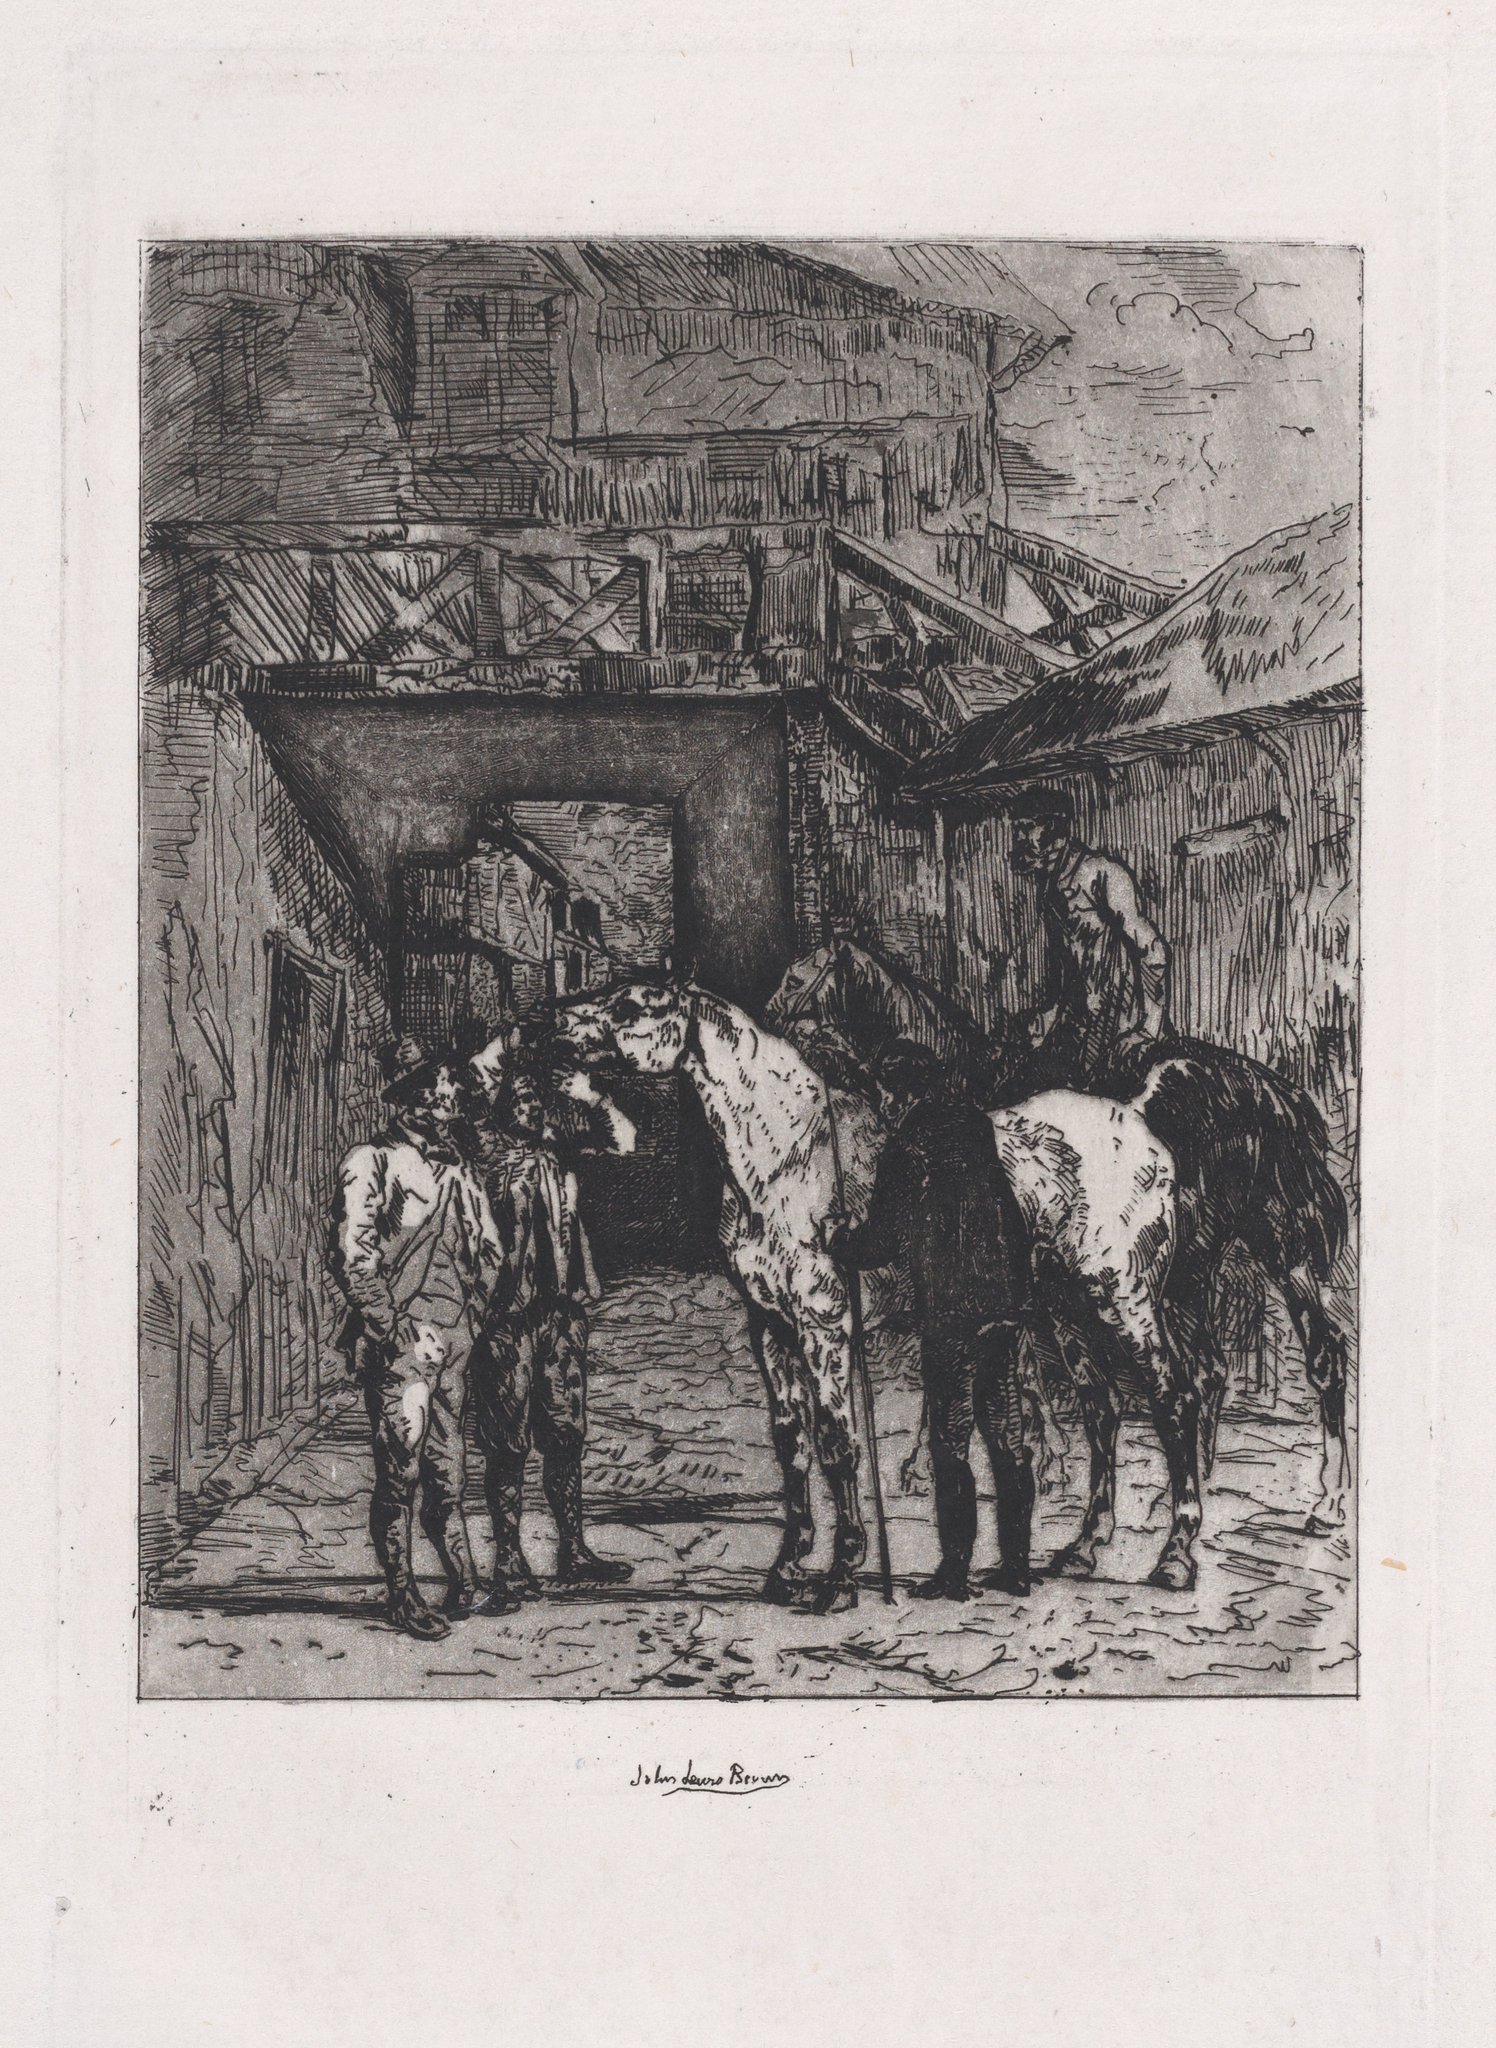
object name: print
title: Le Maquignon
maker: john-lewis brown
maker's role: artist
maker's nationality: french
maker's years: 1829-1890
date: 1801-1900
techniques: aquatint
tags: men,horses